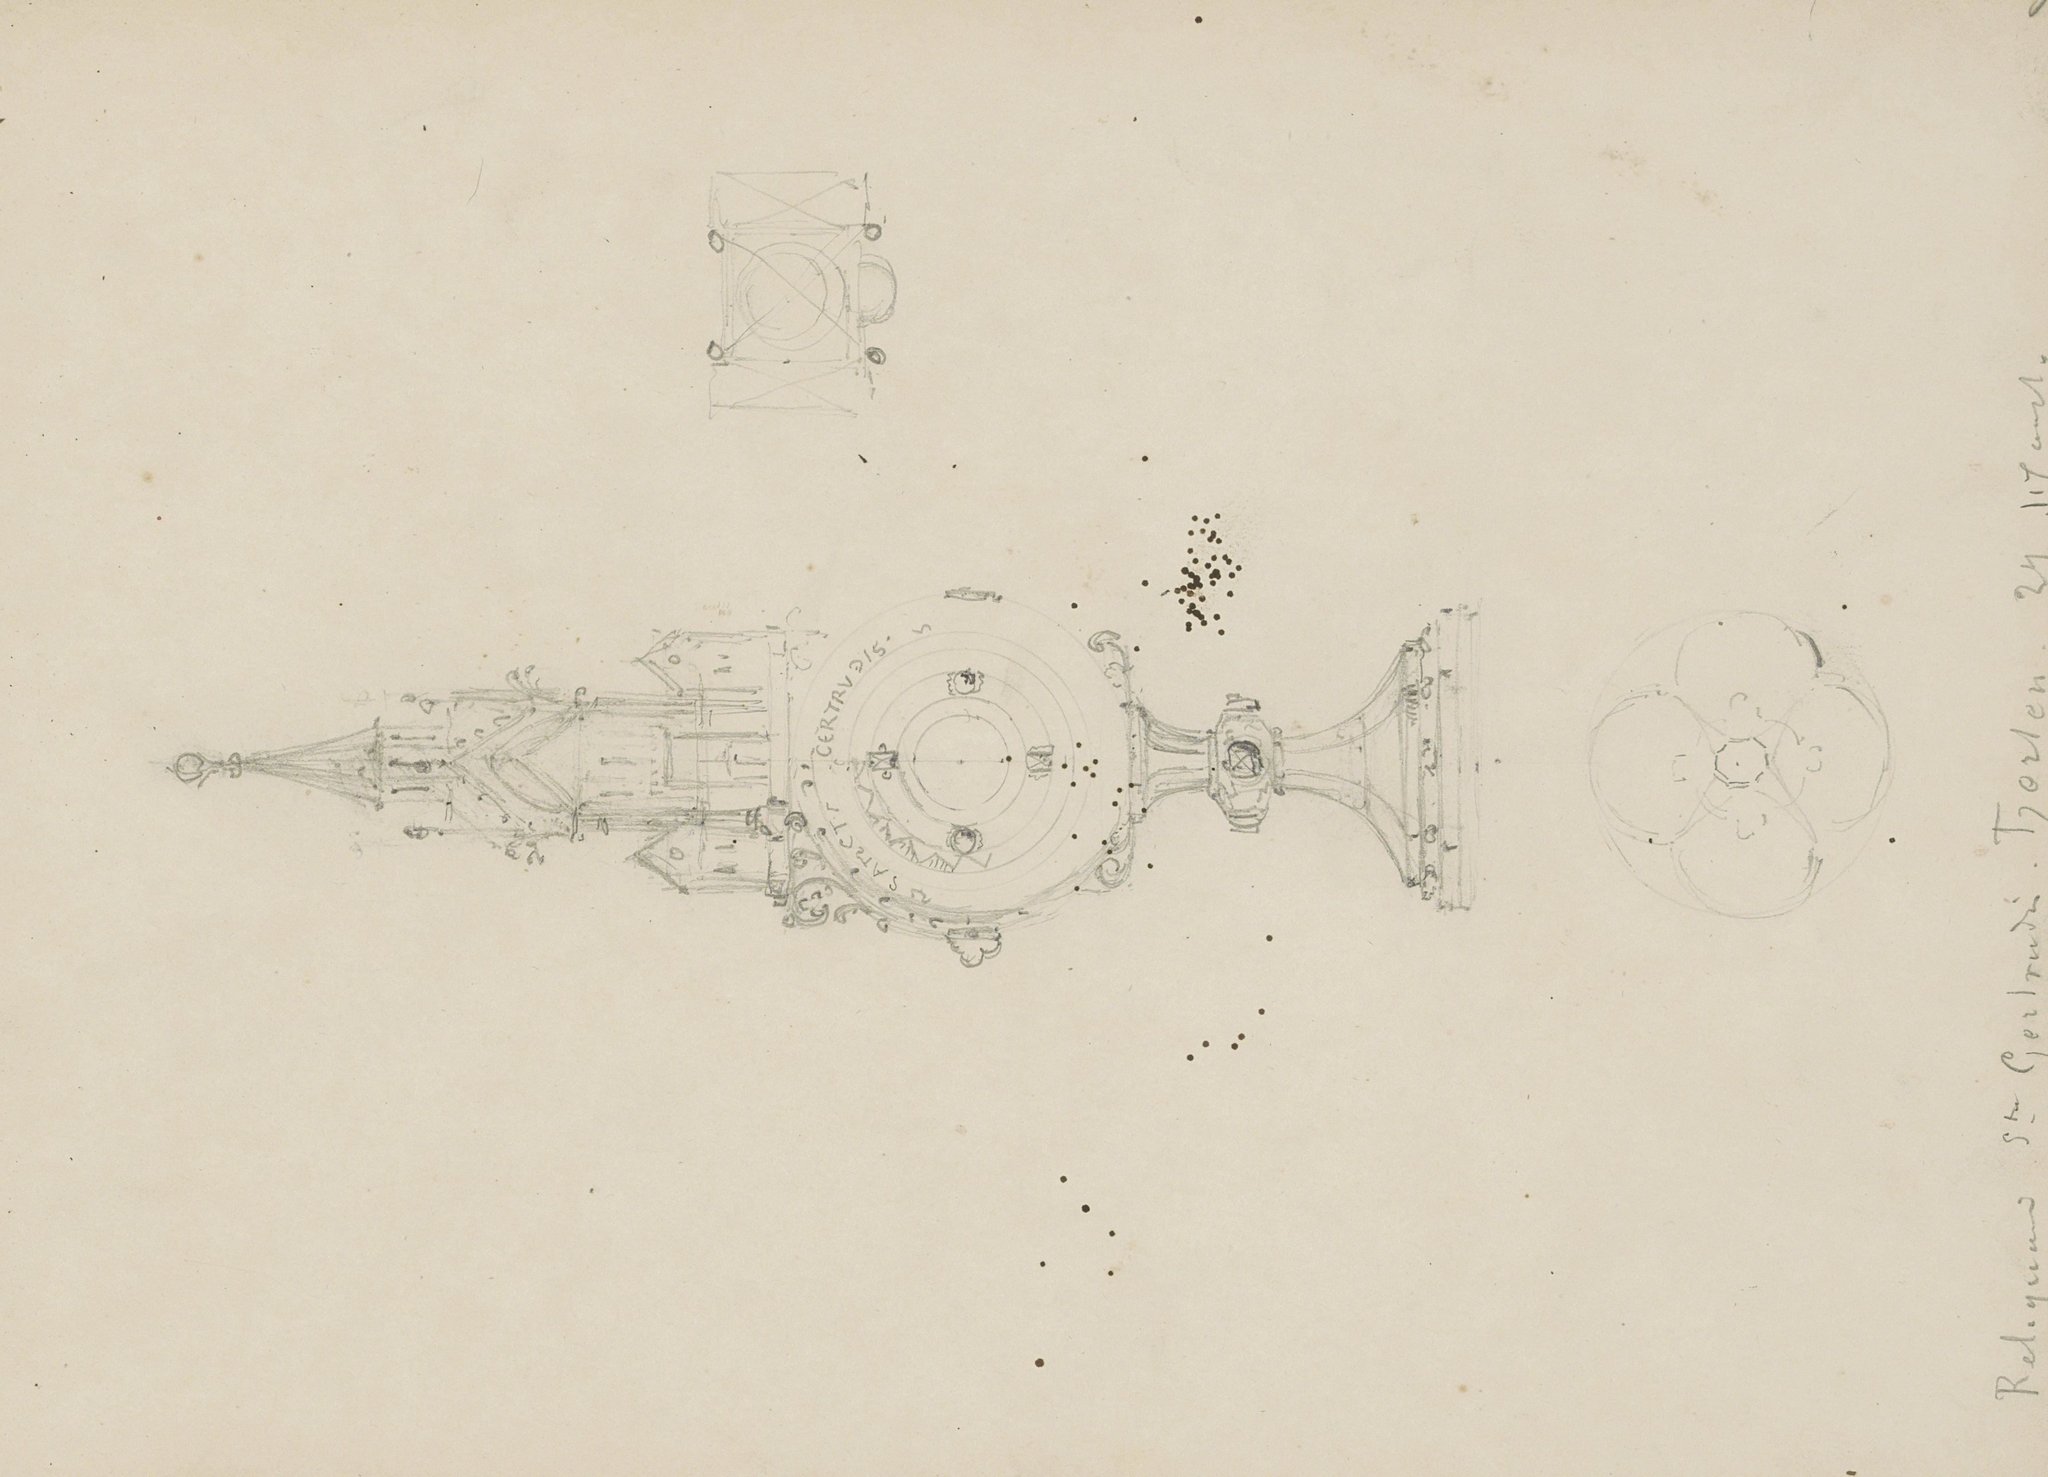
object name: sketchbook leaf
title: Reliekschrijn van de Heilige Gertrudis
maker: pierre joseph hubert cuypers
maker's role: draughtsman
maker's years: 1827-1921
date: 1857-1859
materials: paper, pencil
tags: relics (and reliquaries)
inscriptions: annotation: ‘Reliquaire/ St Gertrudis Herten 24 [...]’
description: Mogelijk decoratie voor de Sint-Gertrudiskerk te Jabeek, welke in 1858-1859 naar ontwerp van Cuypers is gebouwd.